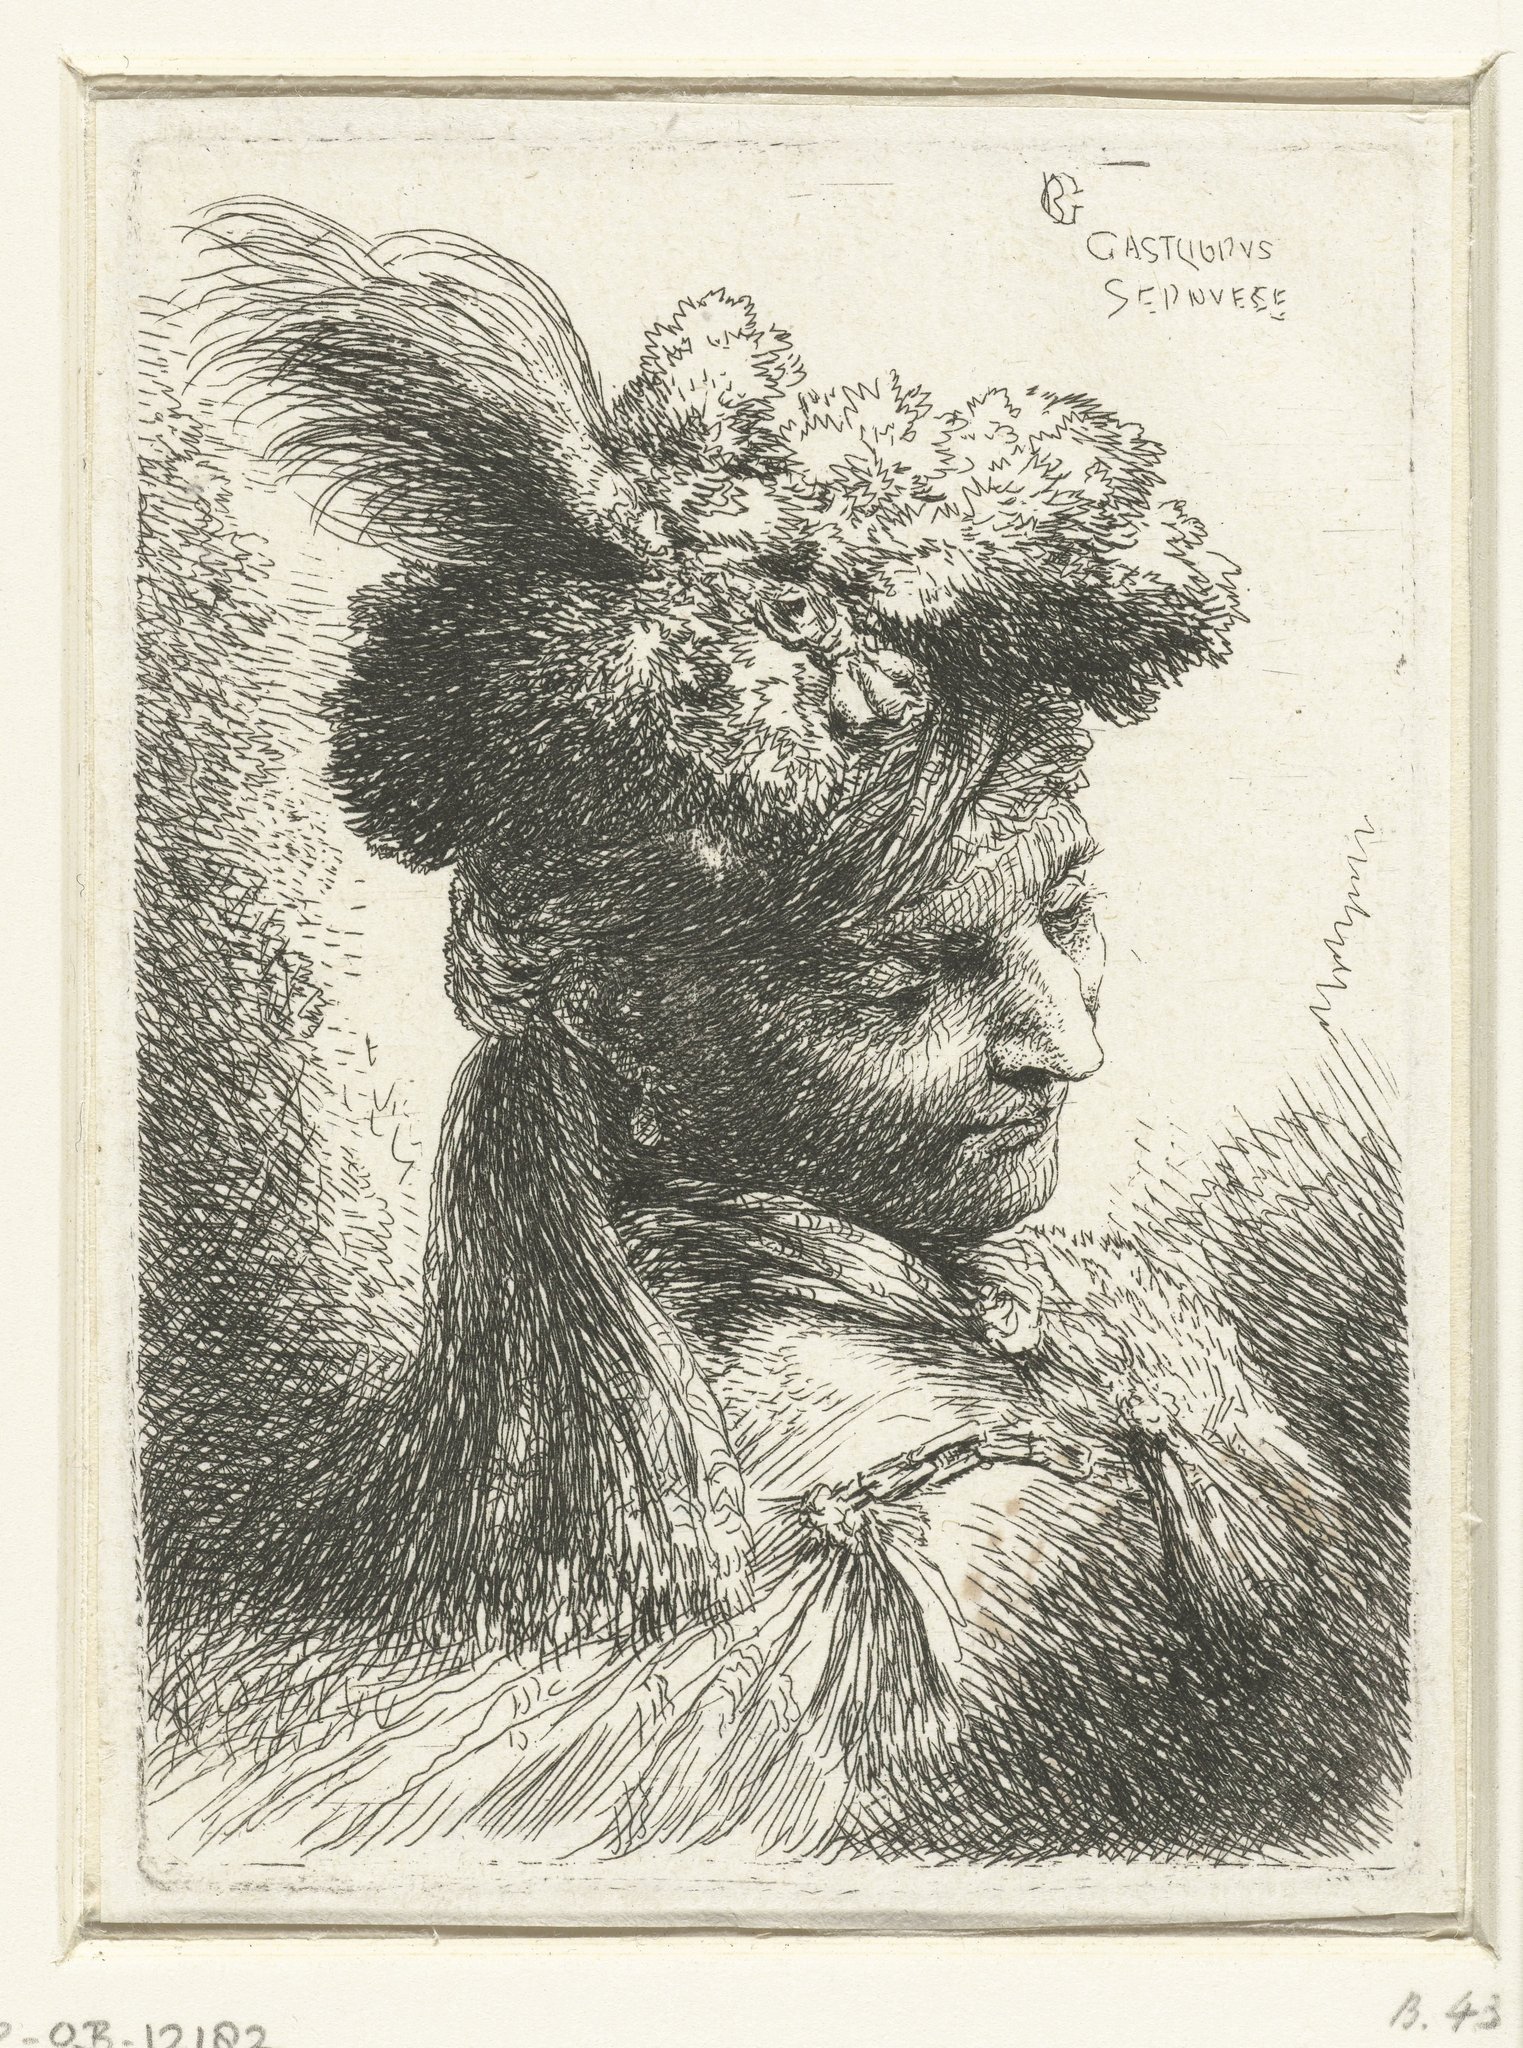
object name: print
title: Hoofd van een jongeman met een oorbel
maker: giovanni benedetto castiglione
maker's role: draughtsman, print maker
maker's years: 1610-1665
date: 1645-1650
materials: paper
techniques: etching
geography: italy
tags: head (human), head-gear: turban (+ men's clothes), ear-rings (+ men's clothes), head-gear: turban (+ feathers used for clothes)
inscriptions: collector's mark: Lugt 240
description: Een jongeman met een oorbel, op de rug gezien, kijkend naar zijn rechter schouder. Hij draagt een tulband met een pluim en een stuk bont. Prent uit een serie van zestien.